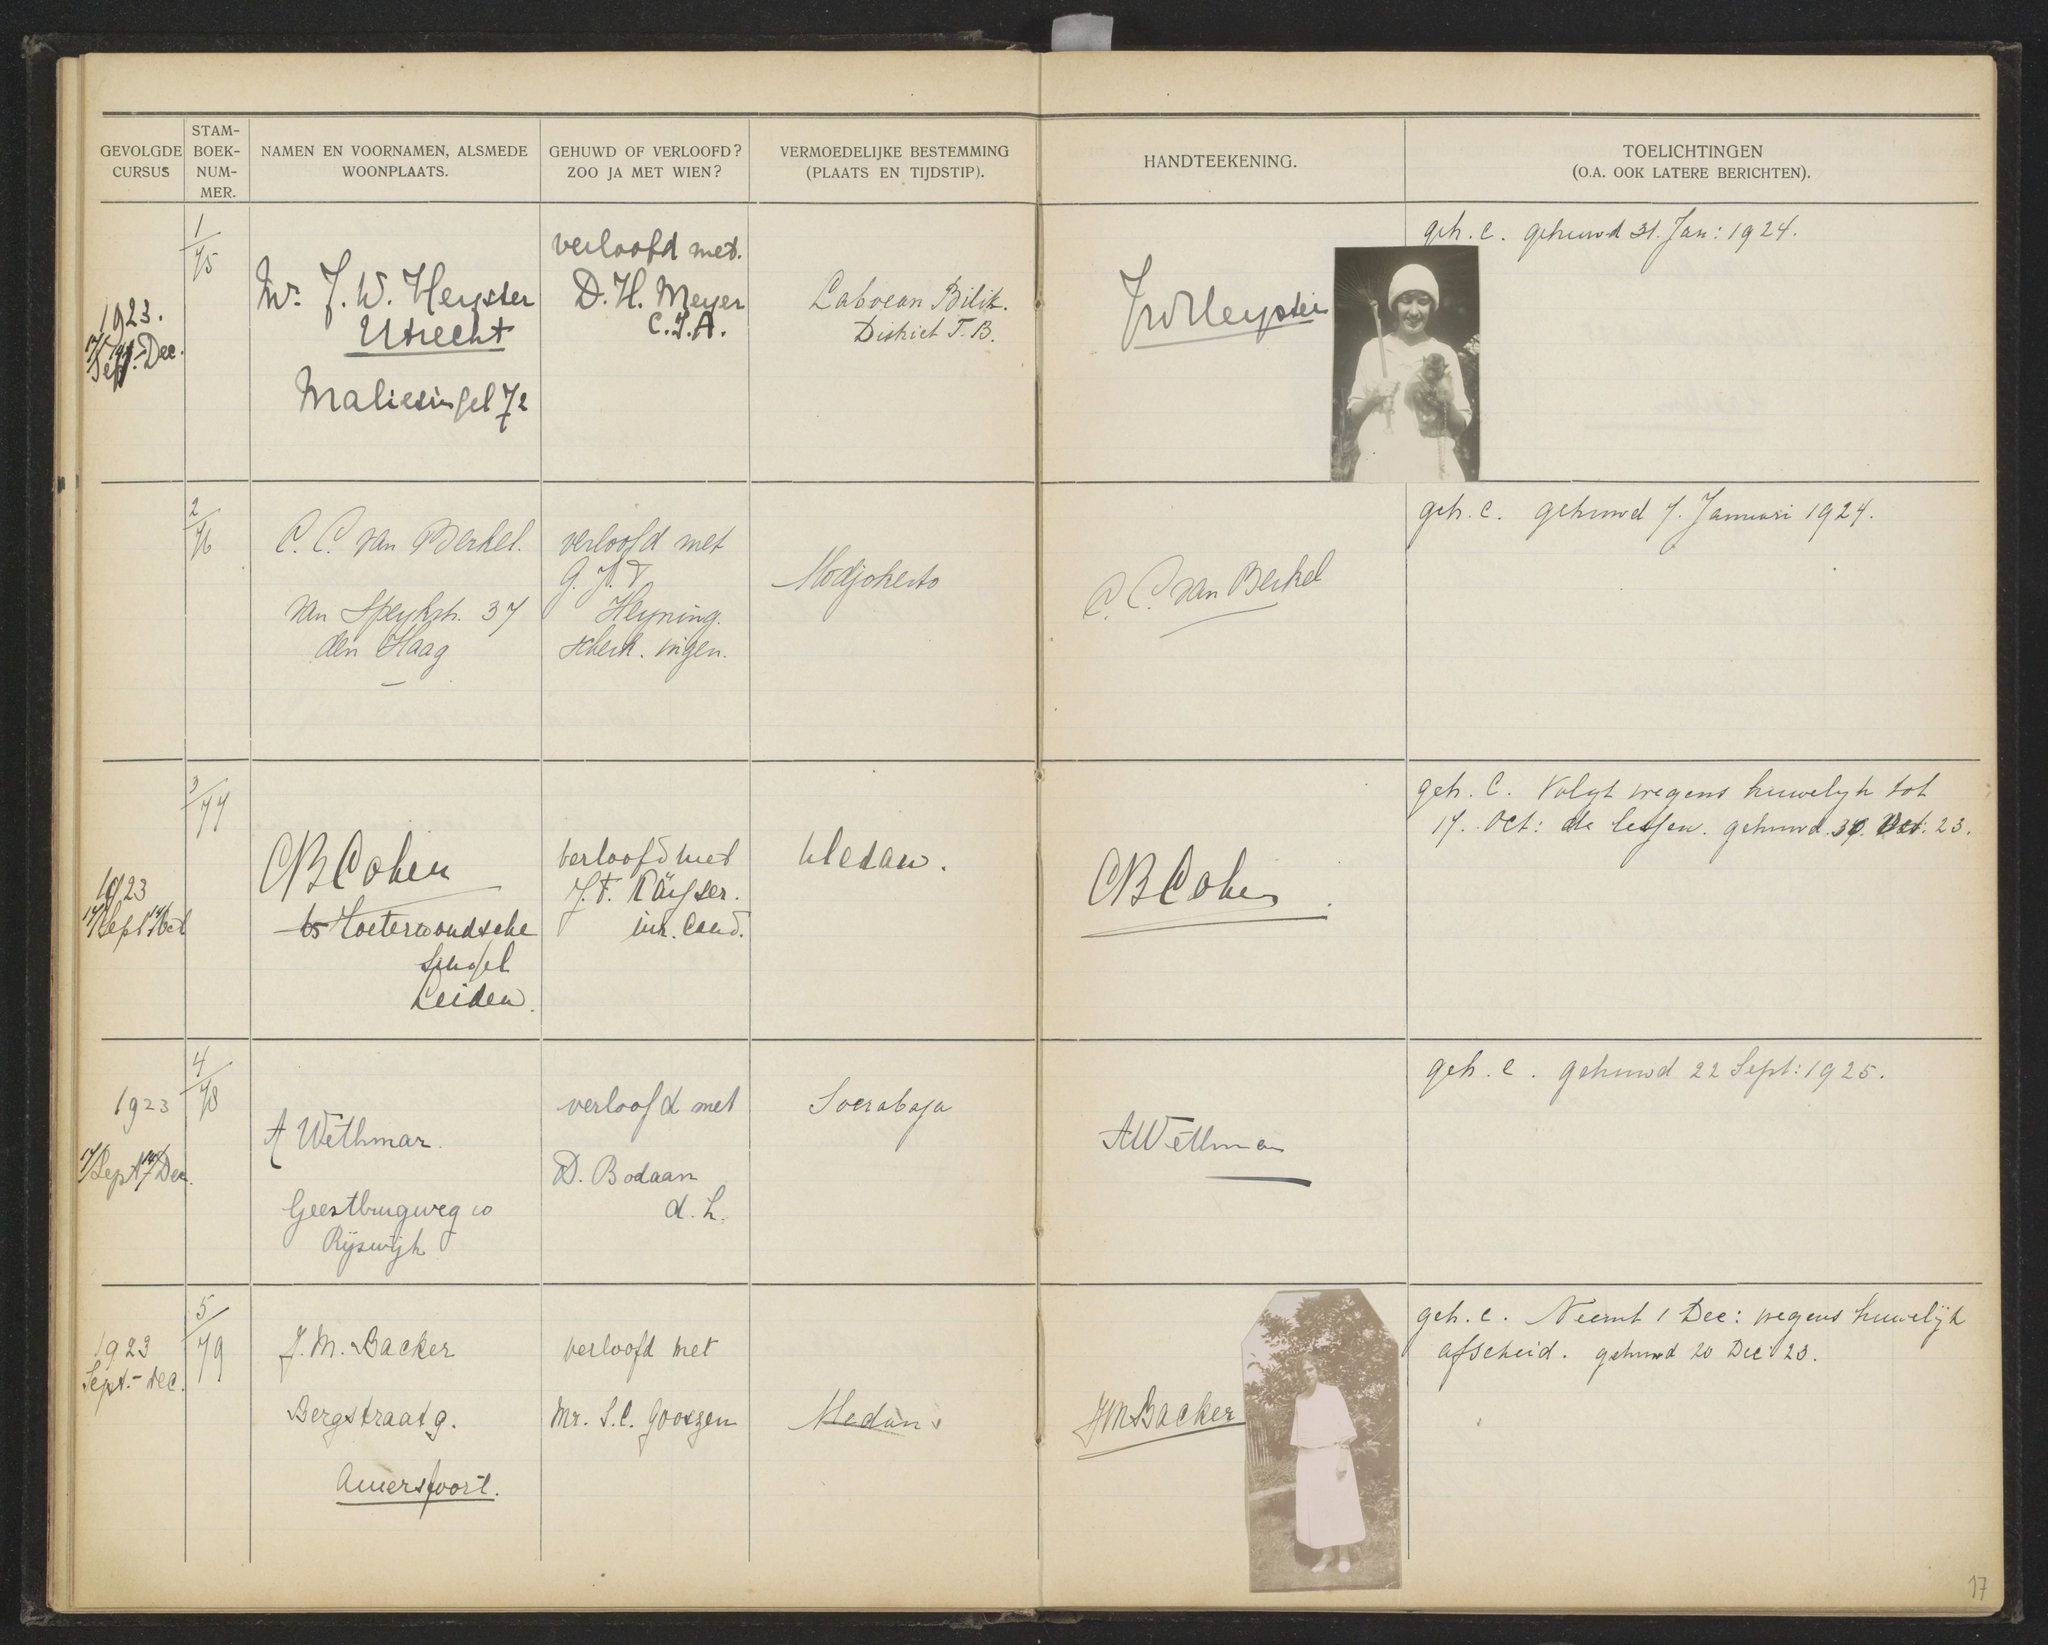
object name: photograph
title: Blad 17 uit Stamboek van de leerlingen der Koloniale School voor Meisjes en Vrouwen te 's-Gravenhage deel I (1921-1929)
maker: Anonymous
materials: paper, photographic support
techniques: photography, printing, writing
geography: the hague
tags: further education (+ pupil), further education, the hague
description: Twee pagina's met gegevens van de deelnemers aan de 7e driemaandelijkse cursus van 17 september tot en met 14 december 1923, stamboeknummers 75 tot en met 79. Onderdeel van Stamboek van de leerlingen der Koloniale School voor Meisjes en Vrouwen te 's-Gravenhage deel I (1921-1929).